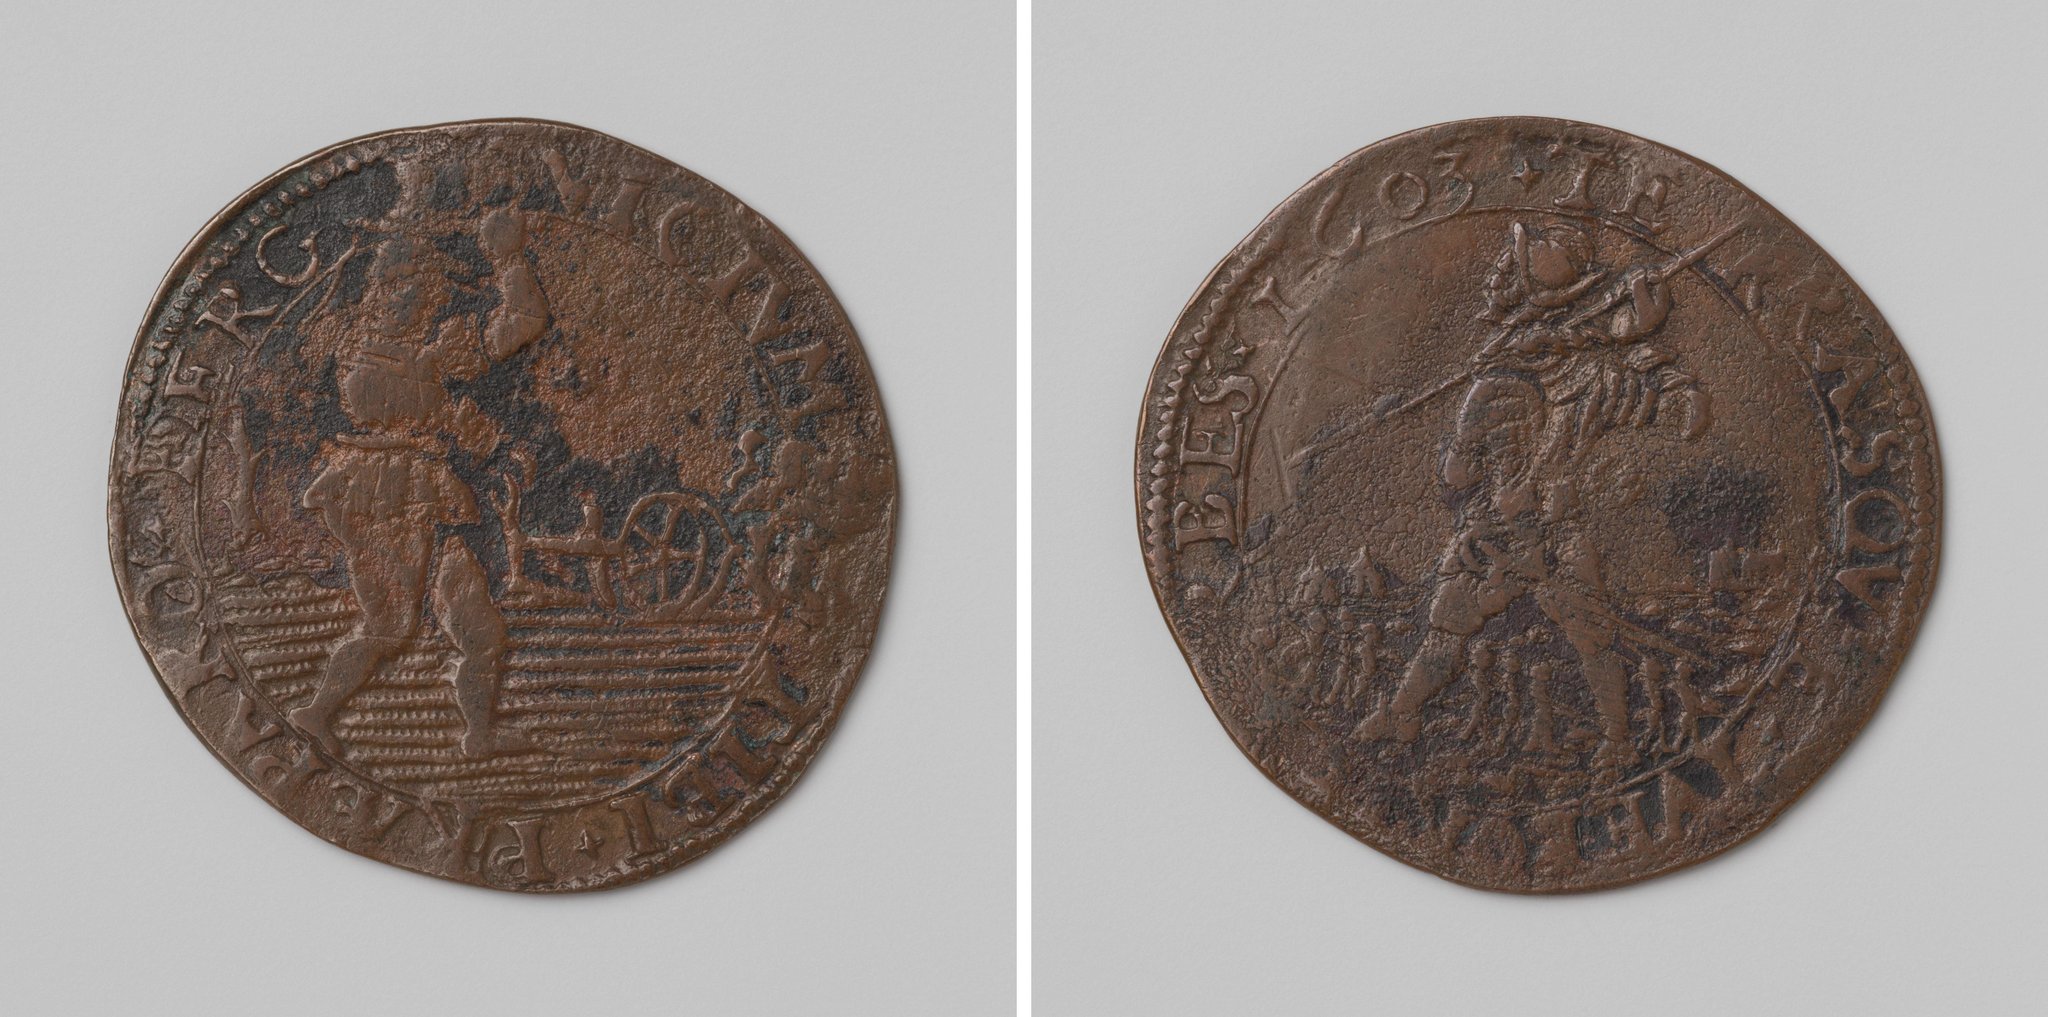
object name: jeton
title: De strijd tegen Spanje bekostigd uit de welvarende economie der Nederlanden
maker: Anonymous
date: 1603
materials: copper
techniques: striking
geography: west frisia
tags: staten van west-friesland, west-friesland, tachtigjarige oorlog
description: Koperen penning. Voorzijde: ploegende boer met zweep boven hoofd binnen omschrift. Keerzijde: gehelmde soldaat met speer in hand; op achtergrond marcherende troepen binnen omschrift